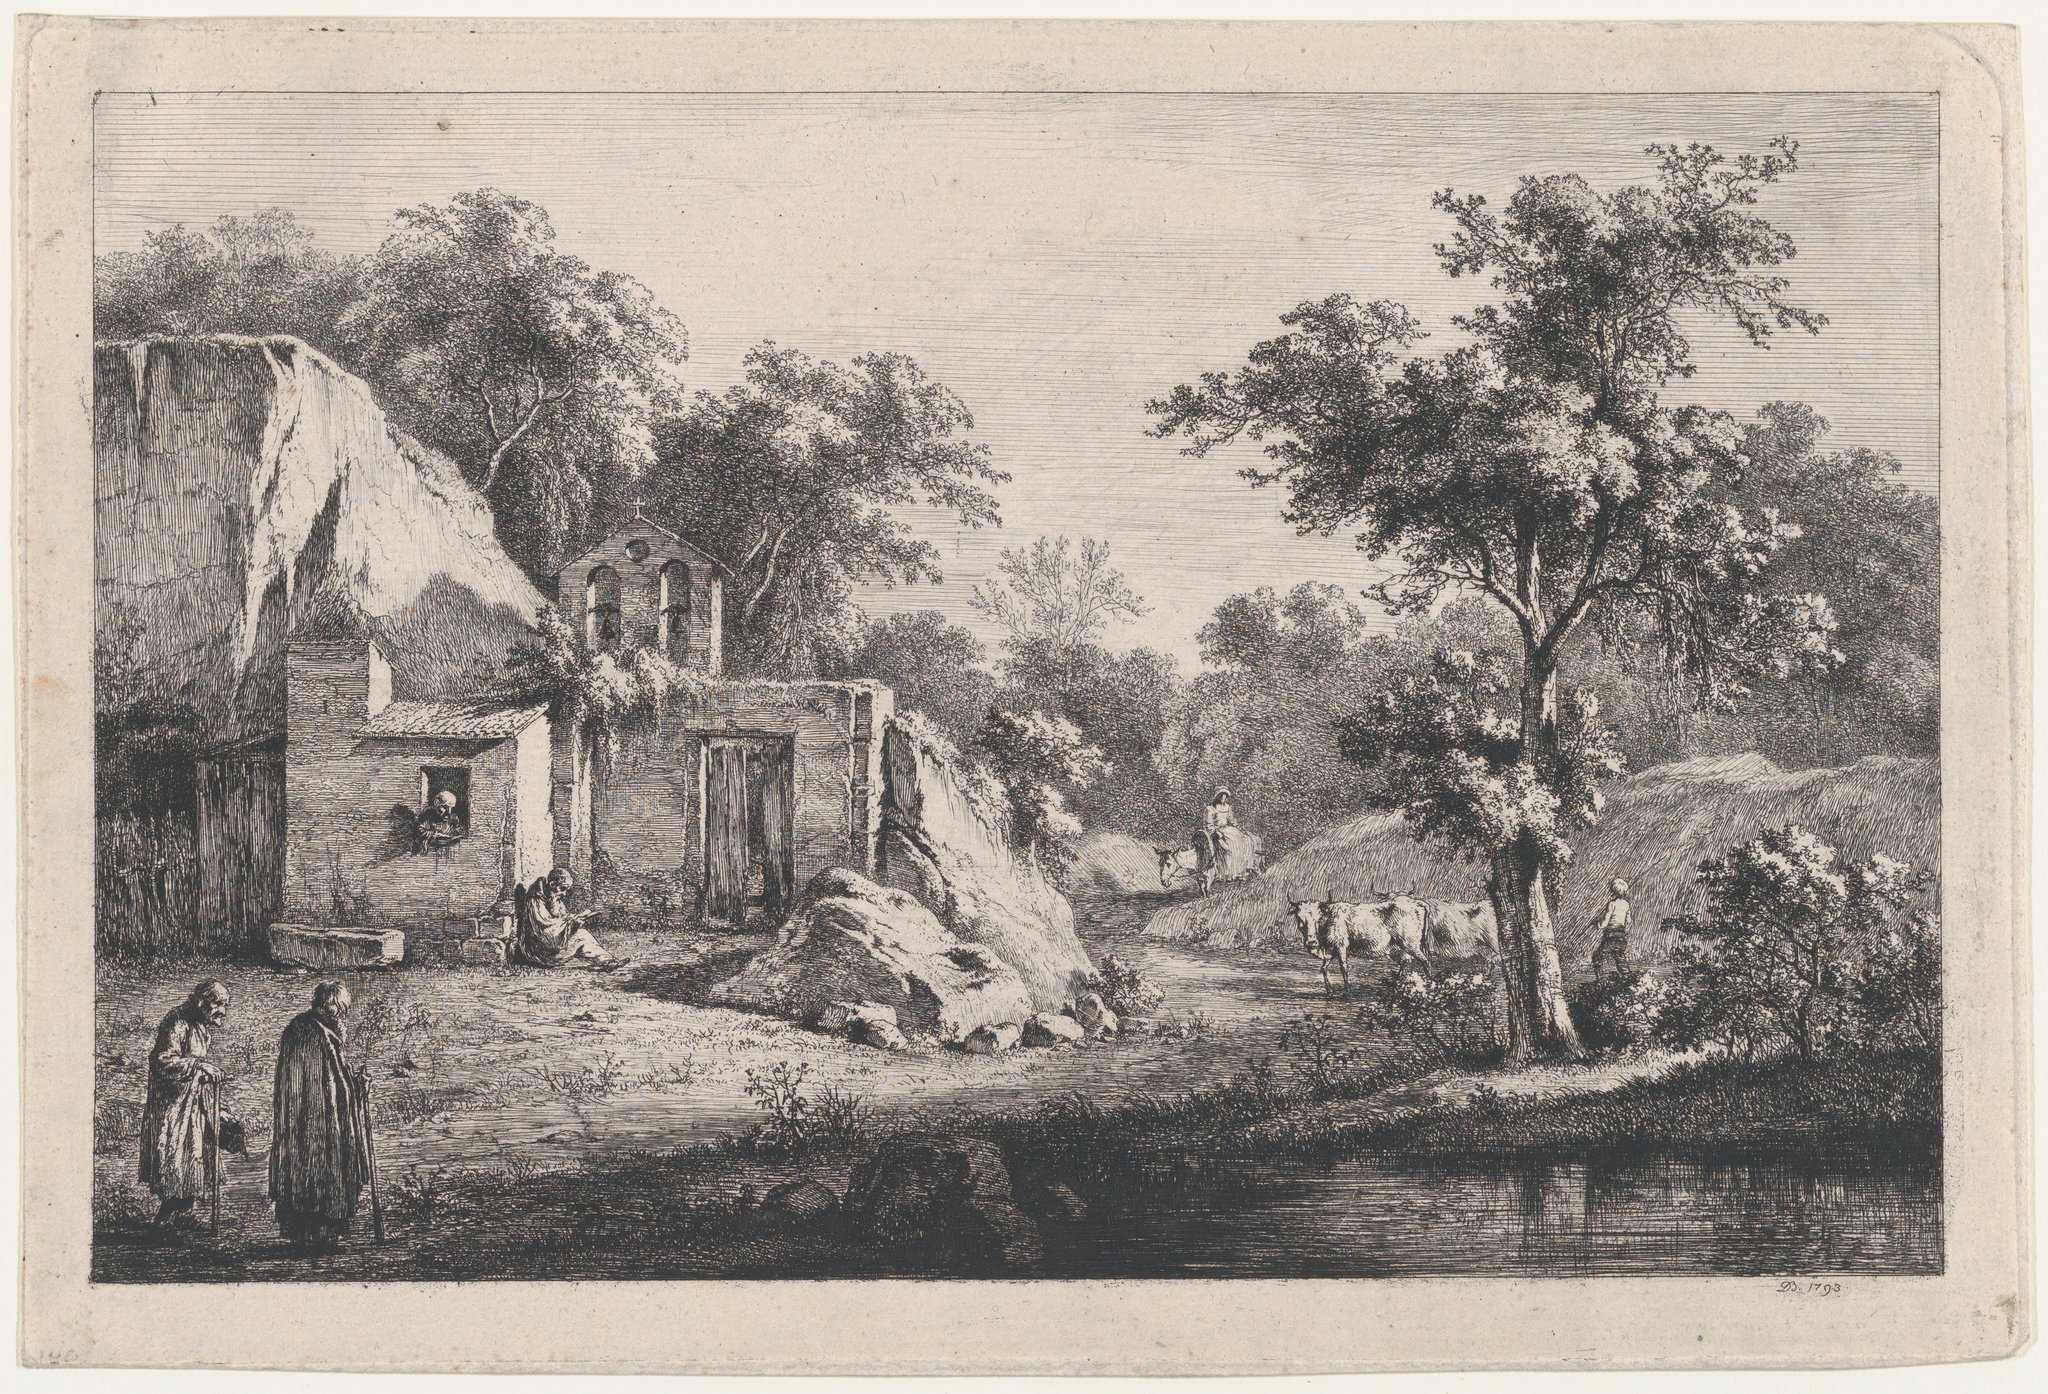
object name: print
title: The Little Hermitage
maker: jean jacques de boissieu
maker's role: artist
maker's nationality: french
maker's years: 1736-1810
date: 1793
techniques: drypoint, etching, roulette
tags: houses,men,cows,landscapes